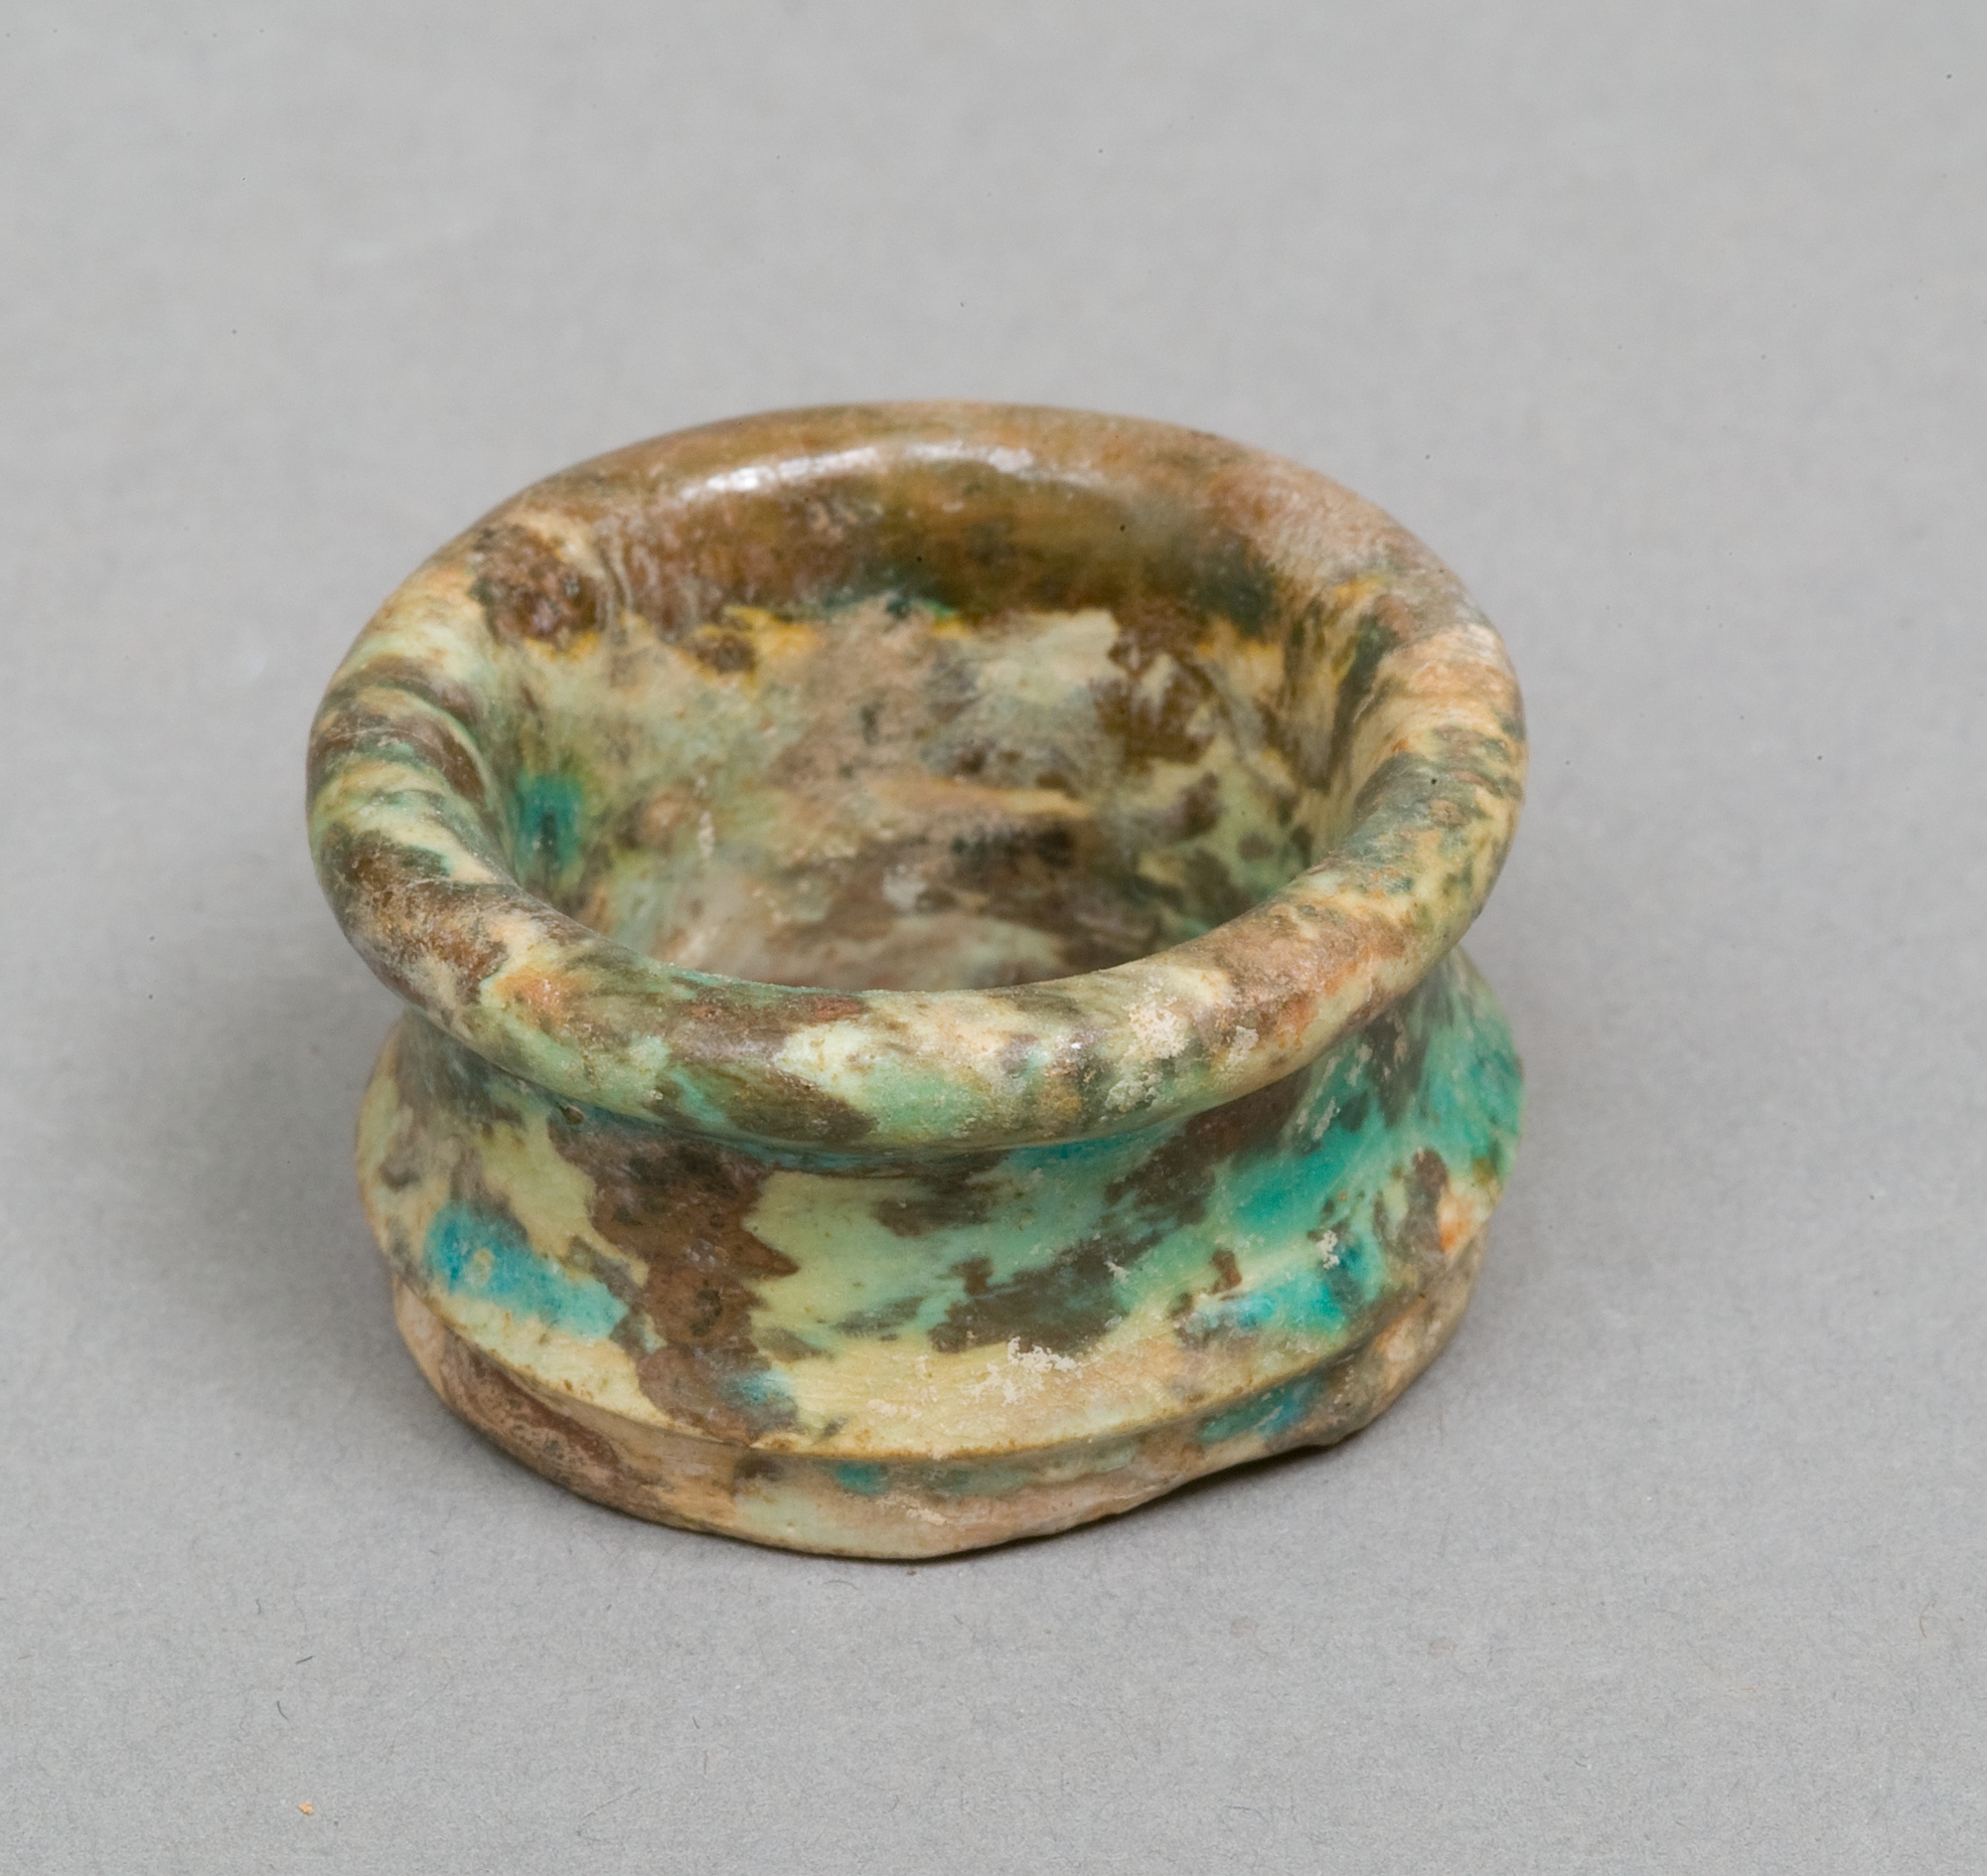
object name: vessel stand, hepy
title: Jar stand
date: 1981-1640 BCE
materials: stone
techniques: glazing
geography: egypt